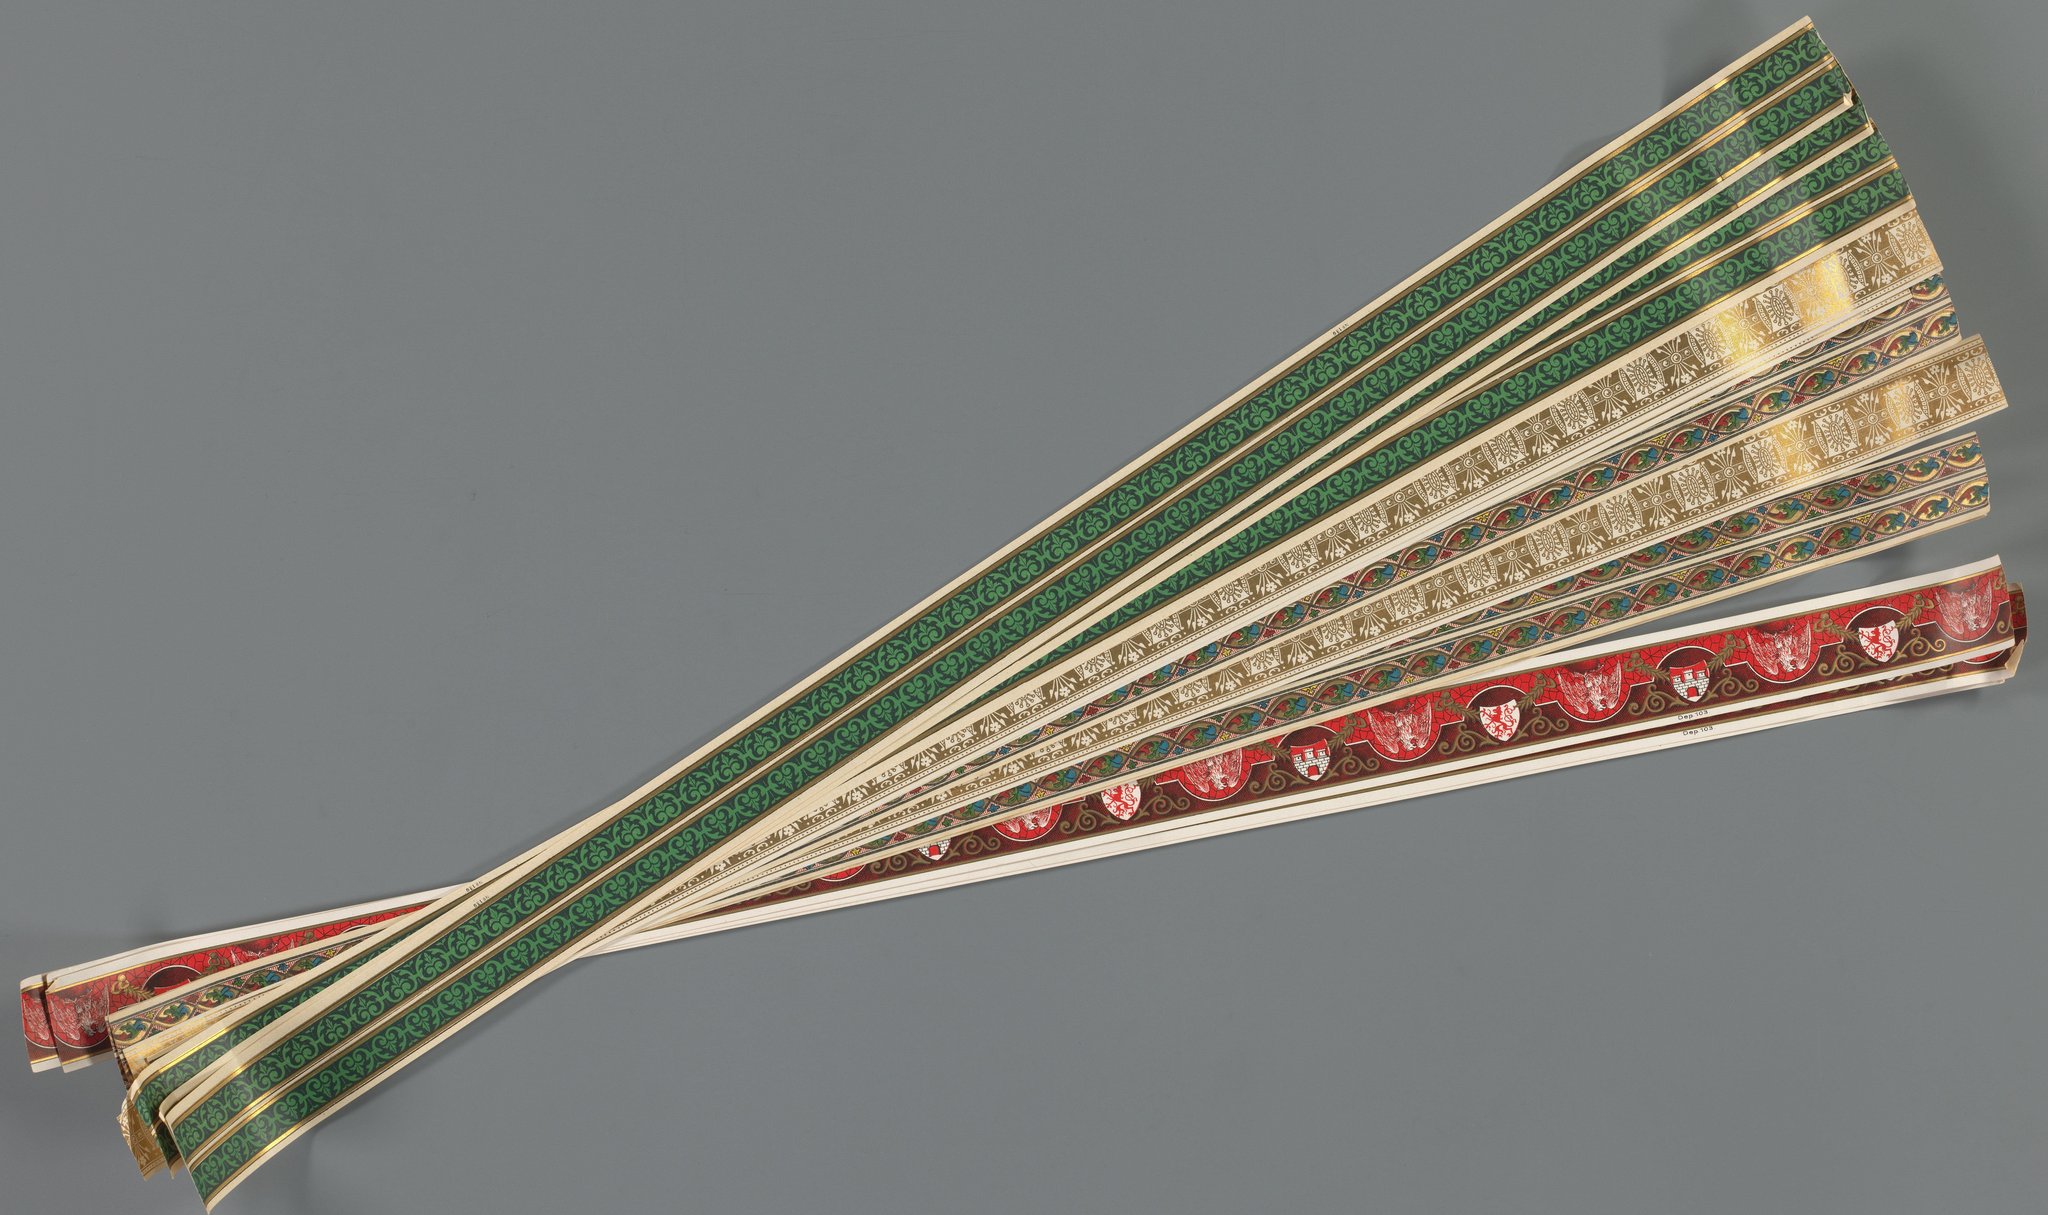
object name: packing material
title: Papieren banden voor sigarenkisten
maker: Anonymous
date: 1930-1960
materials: paper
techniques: lithograph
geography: netherlands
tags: cigar, paper (writing material), tobacco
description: Groep van 12 stuks papieren banden voor sigarenkisten van de Firma Swarttouw sigarenfabrikant en tabakshandelaar, in Delft. Gedrukt in drie ornamentele patronen.